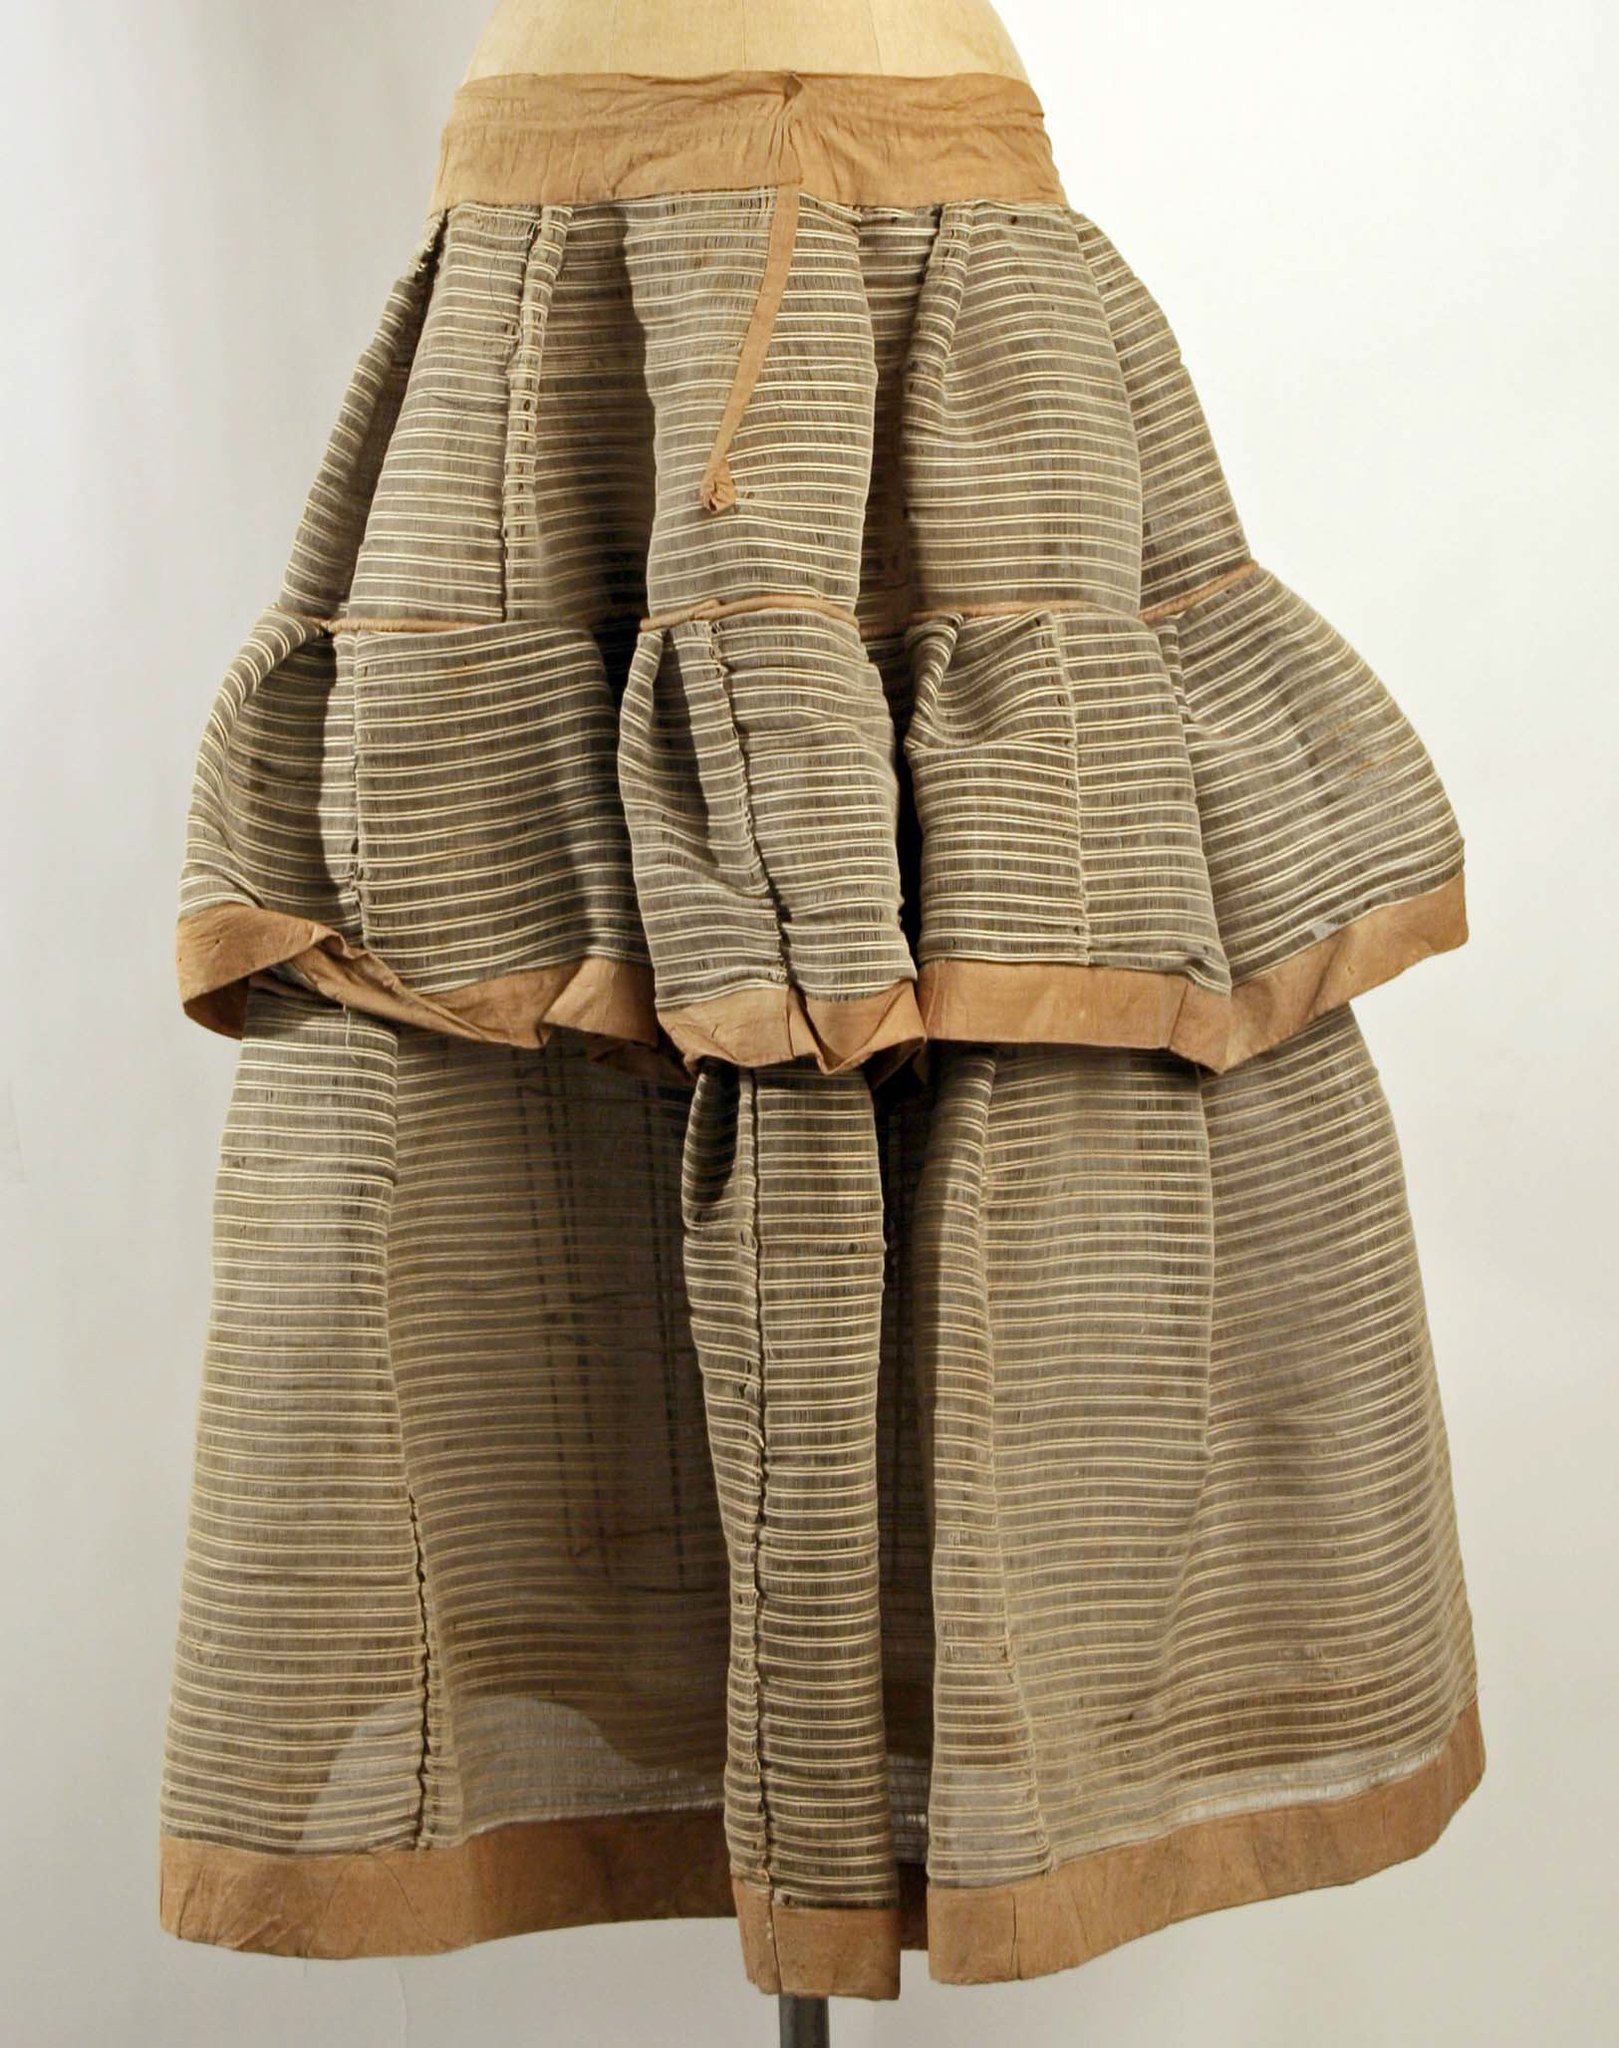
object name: petticoat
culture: american or european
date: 1840-1849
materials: cotton, hair